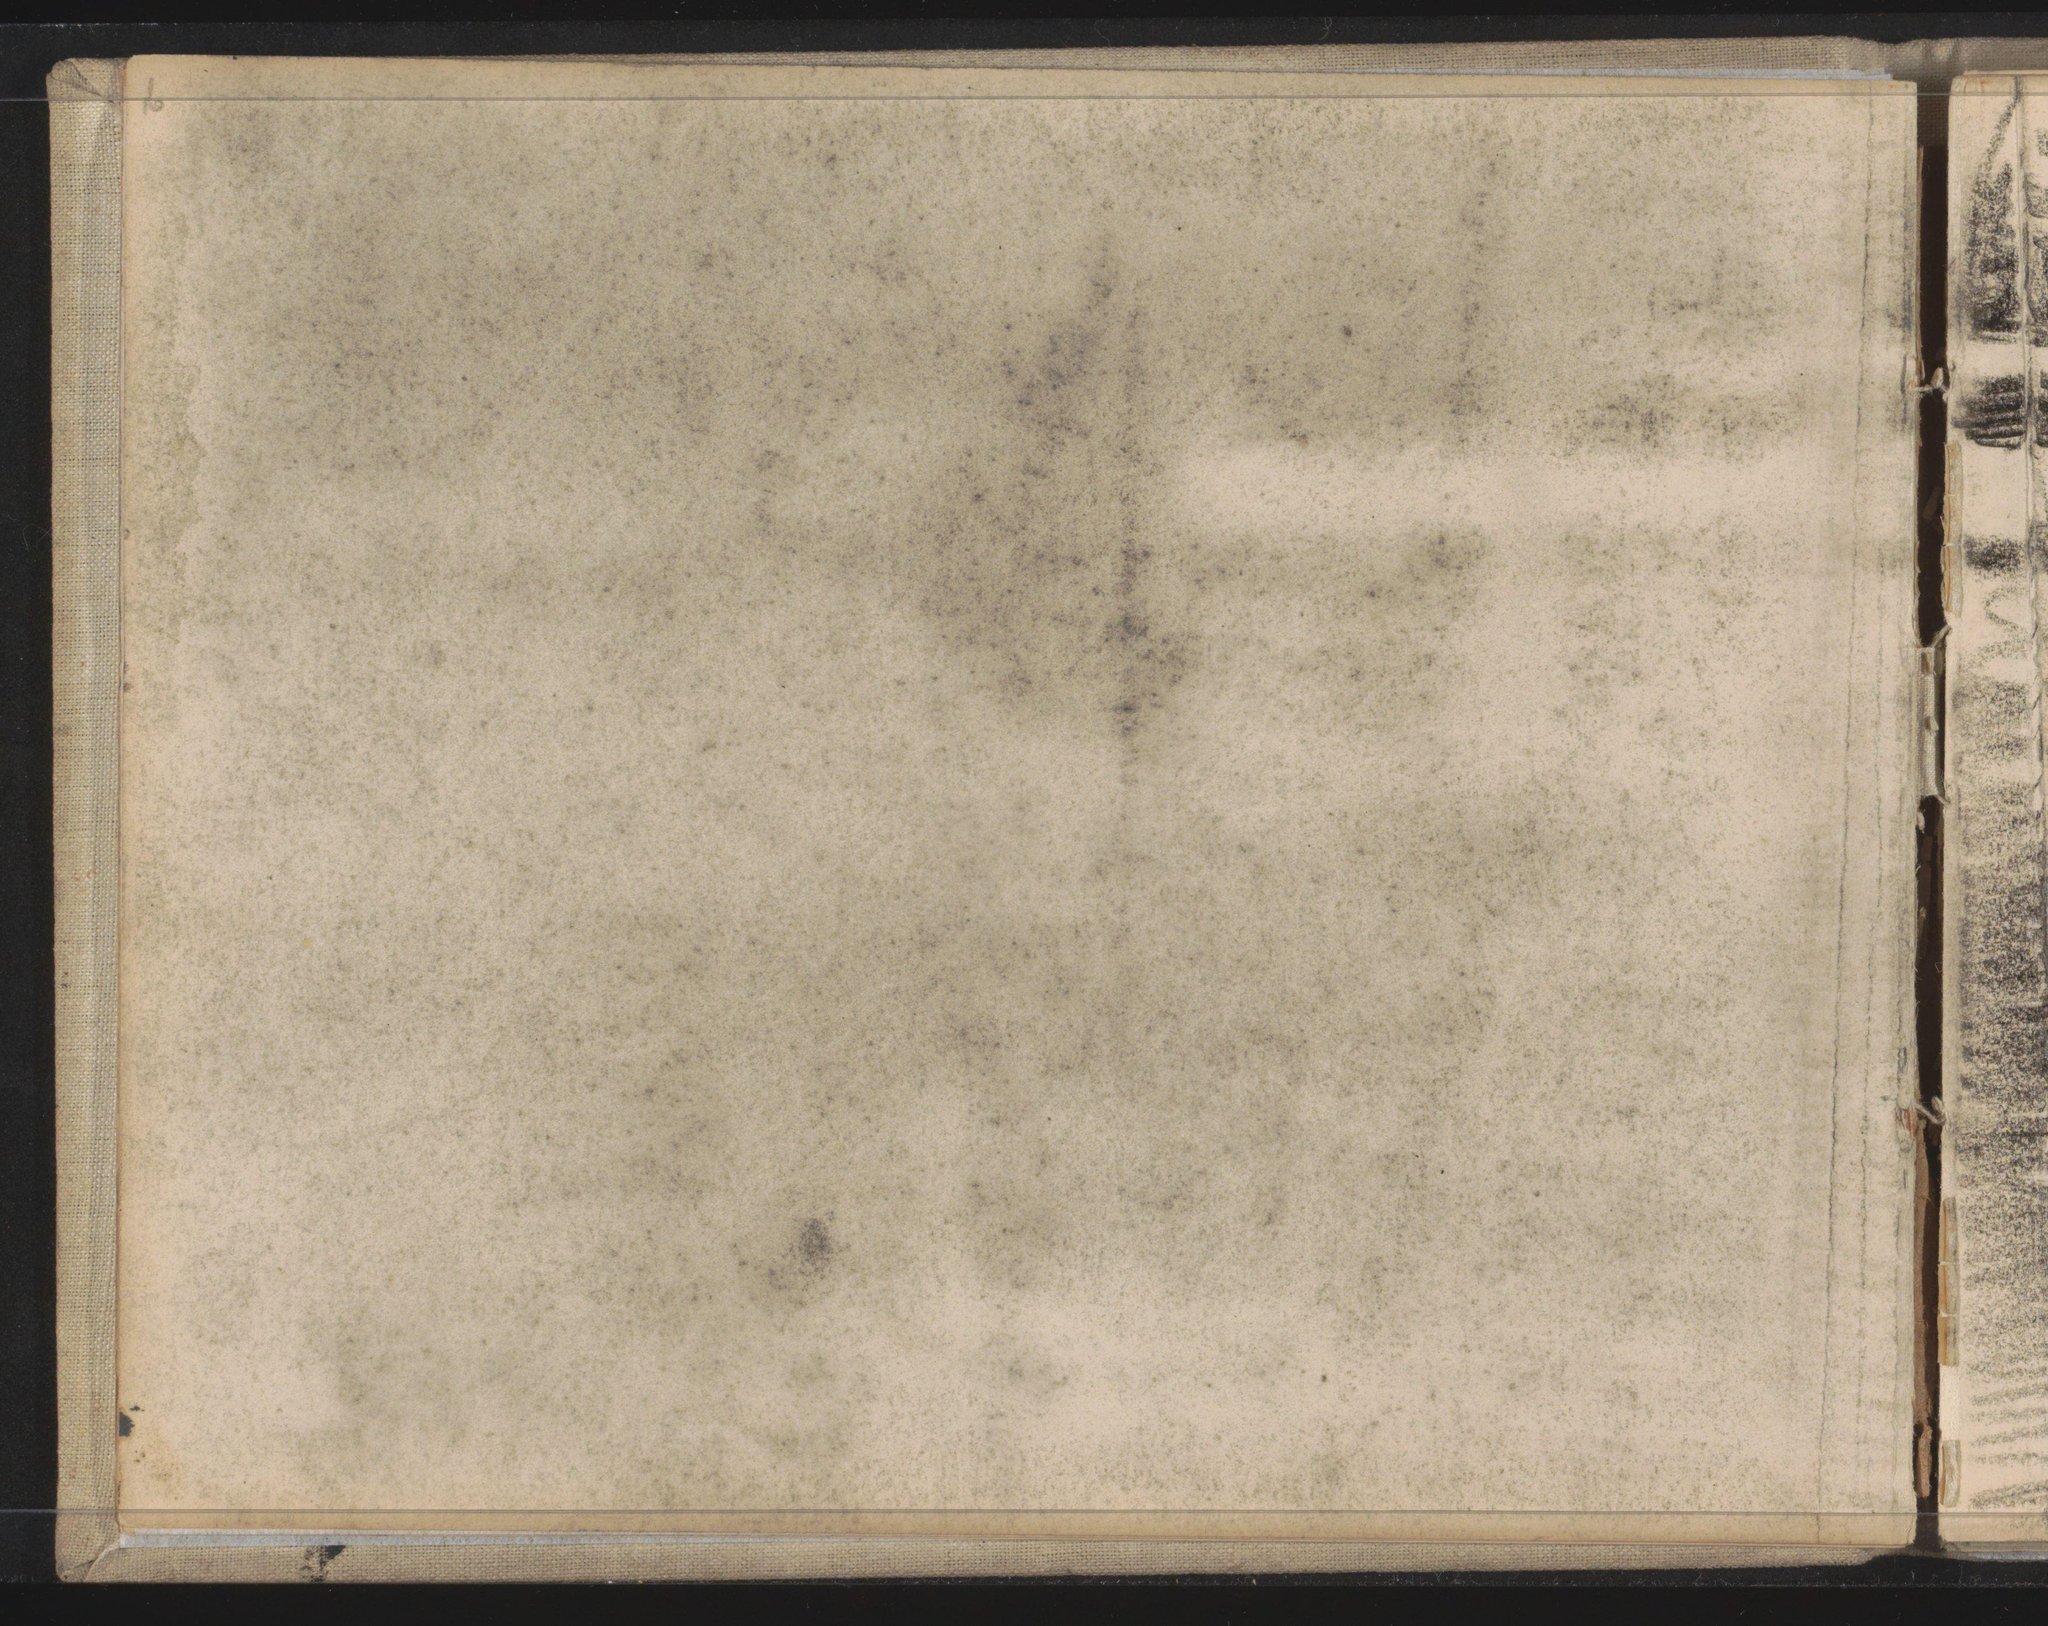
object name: sketchbook leaf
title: Abklatsch van de krijttekening op pagina 17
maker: willem witsen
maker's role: draughtsman, painter, print maker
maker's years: 1860-1923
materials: paper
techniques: printmaking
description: Pagina 16 uit een schetsboek met 43 bladen.